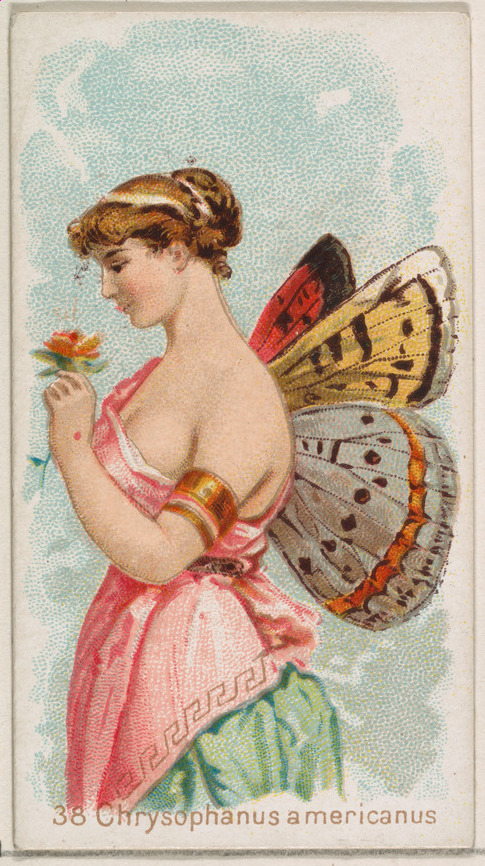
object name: print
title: Card 38, Chysophanus Americanus, from the Butterflies series (N183) issued by Wm. S. Kimball & Co.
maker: william s. kimball & company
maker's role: publisher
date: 1888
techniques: color lithograph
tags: profiles,women,butterflies,flowers